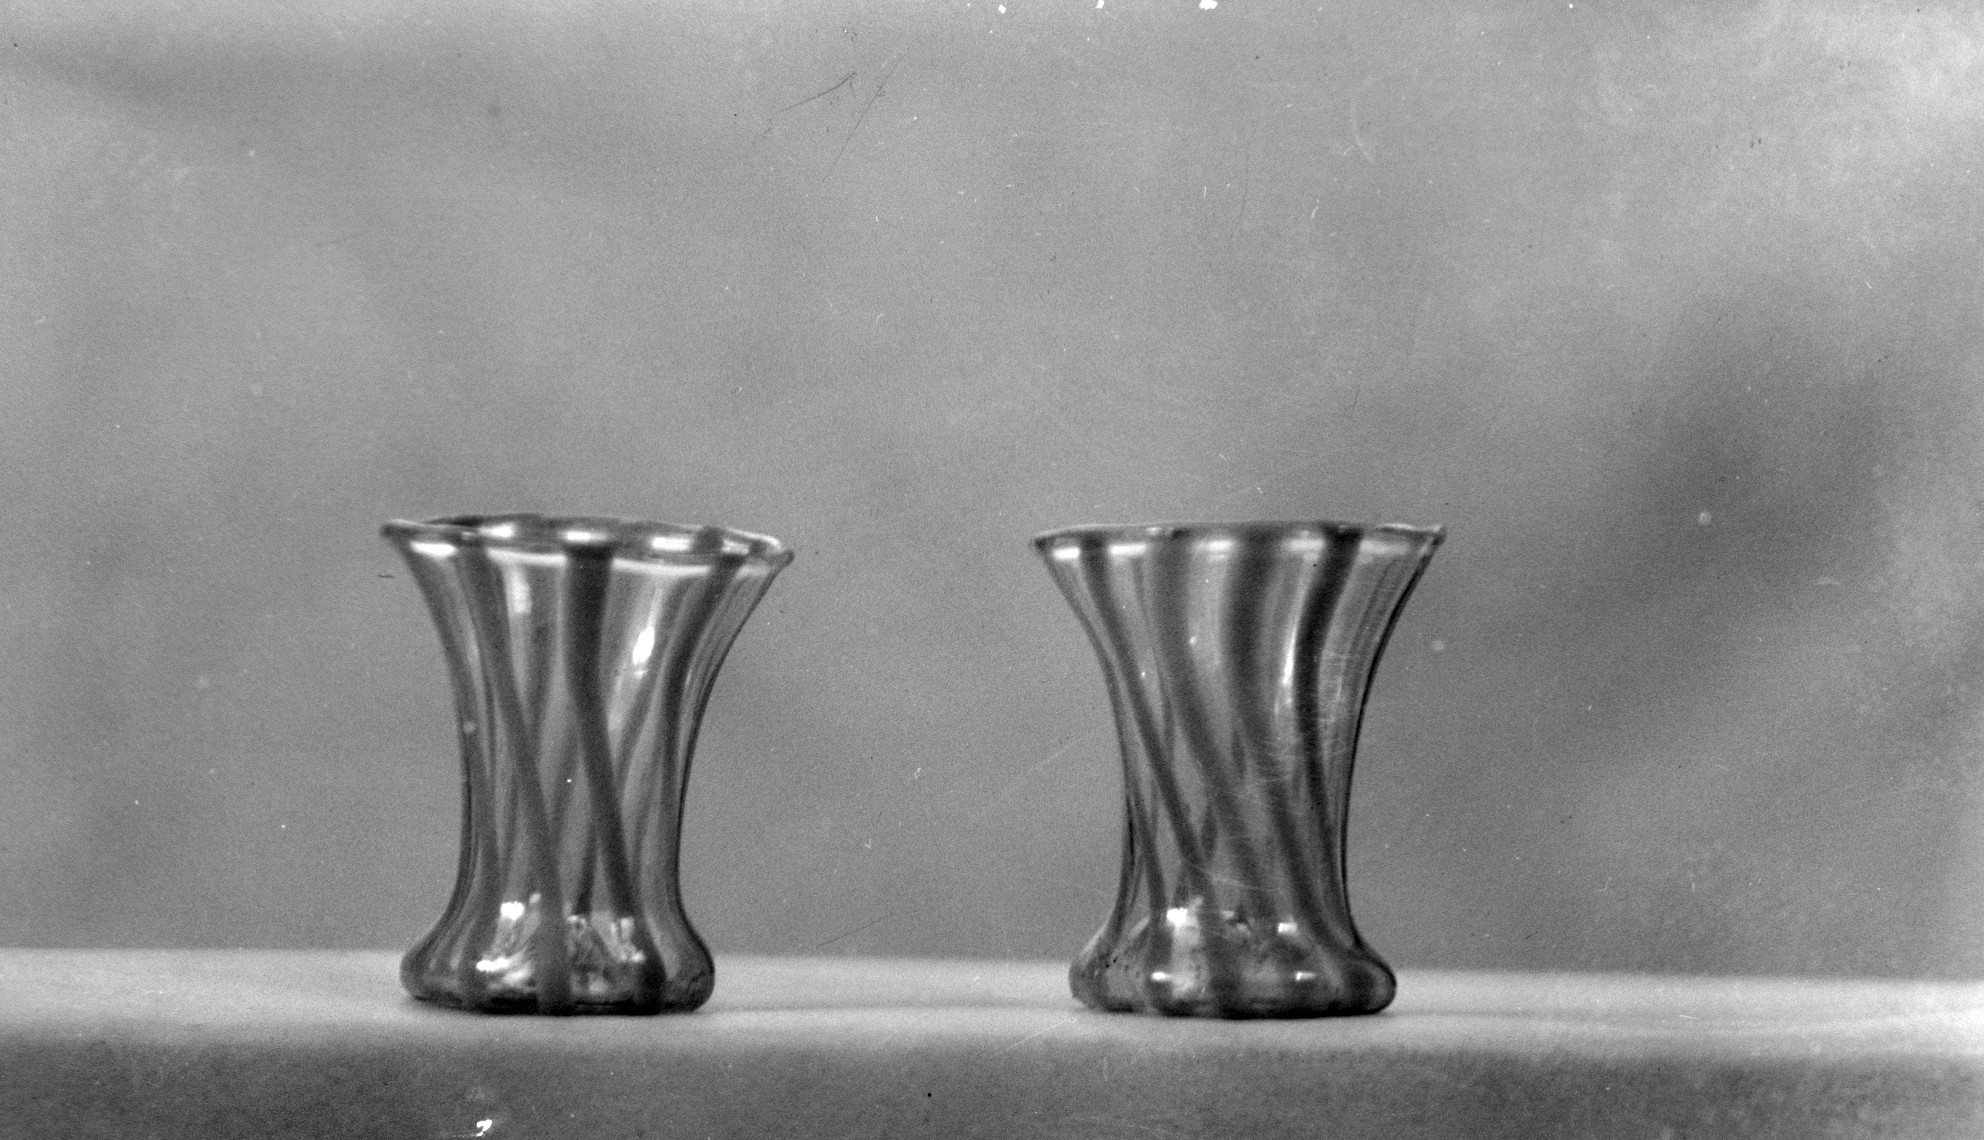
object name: beaker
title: Miniature beaker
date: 1801-1833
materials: glass